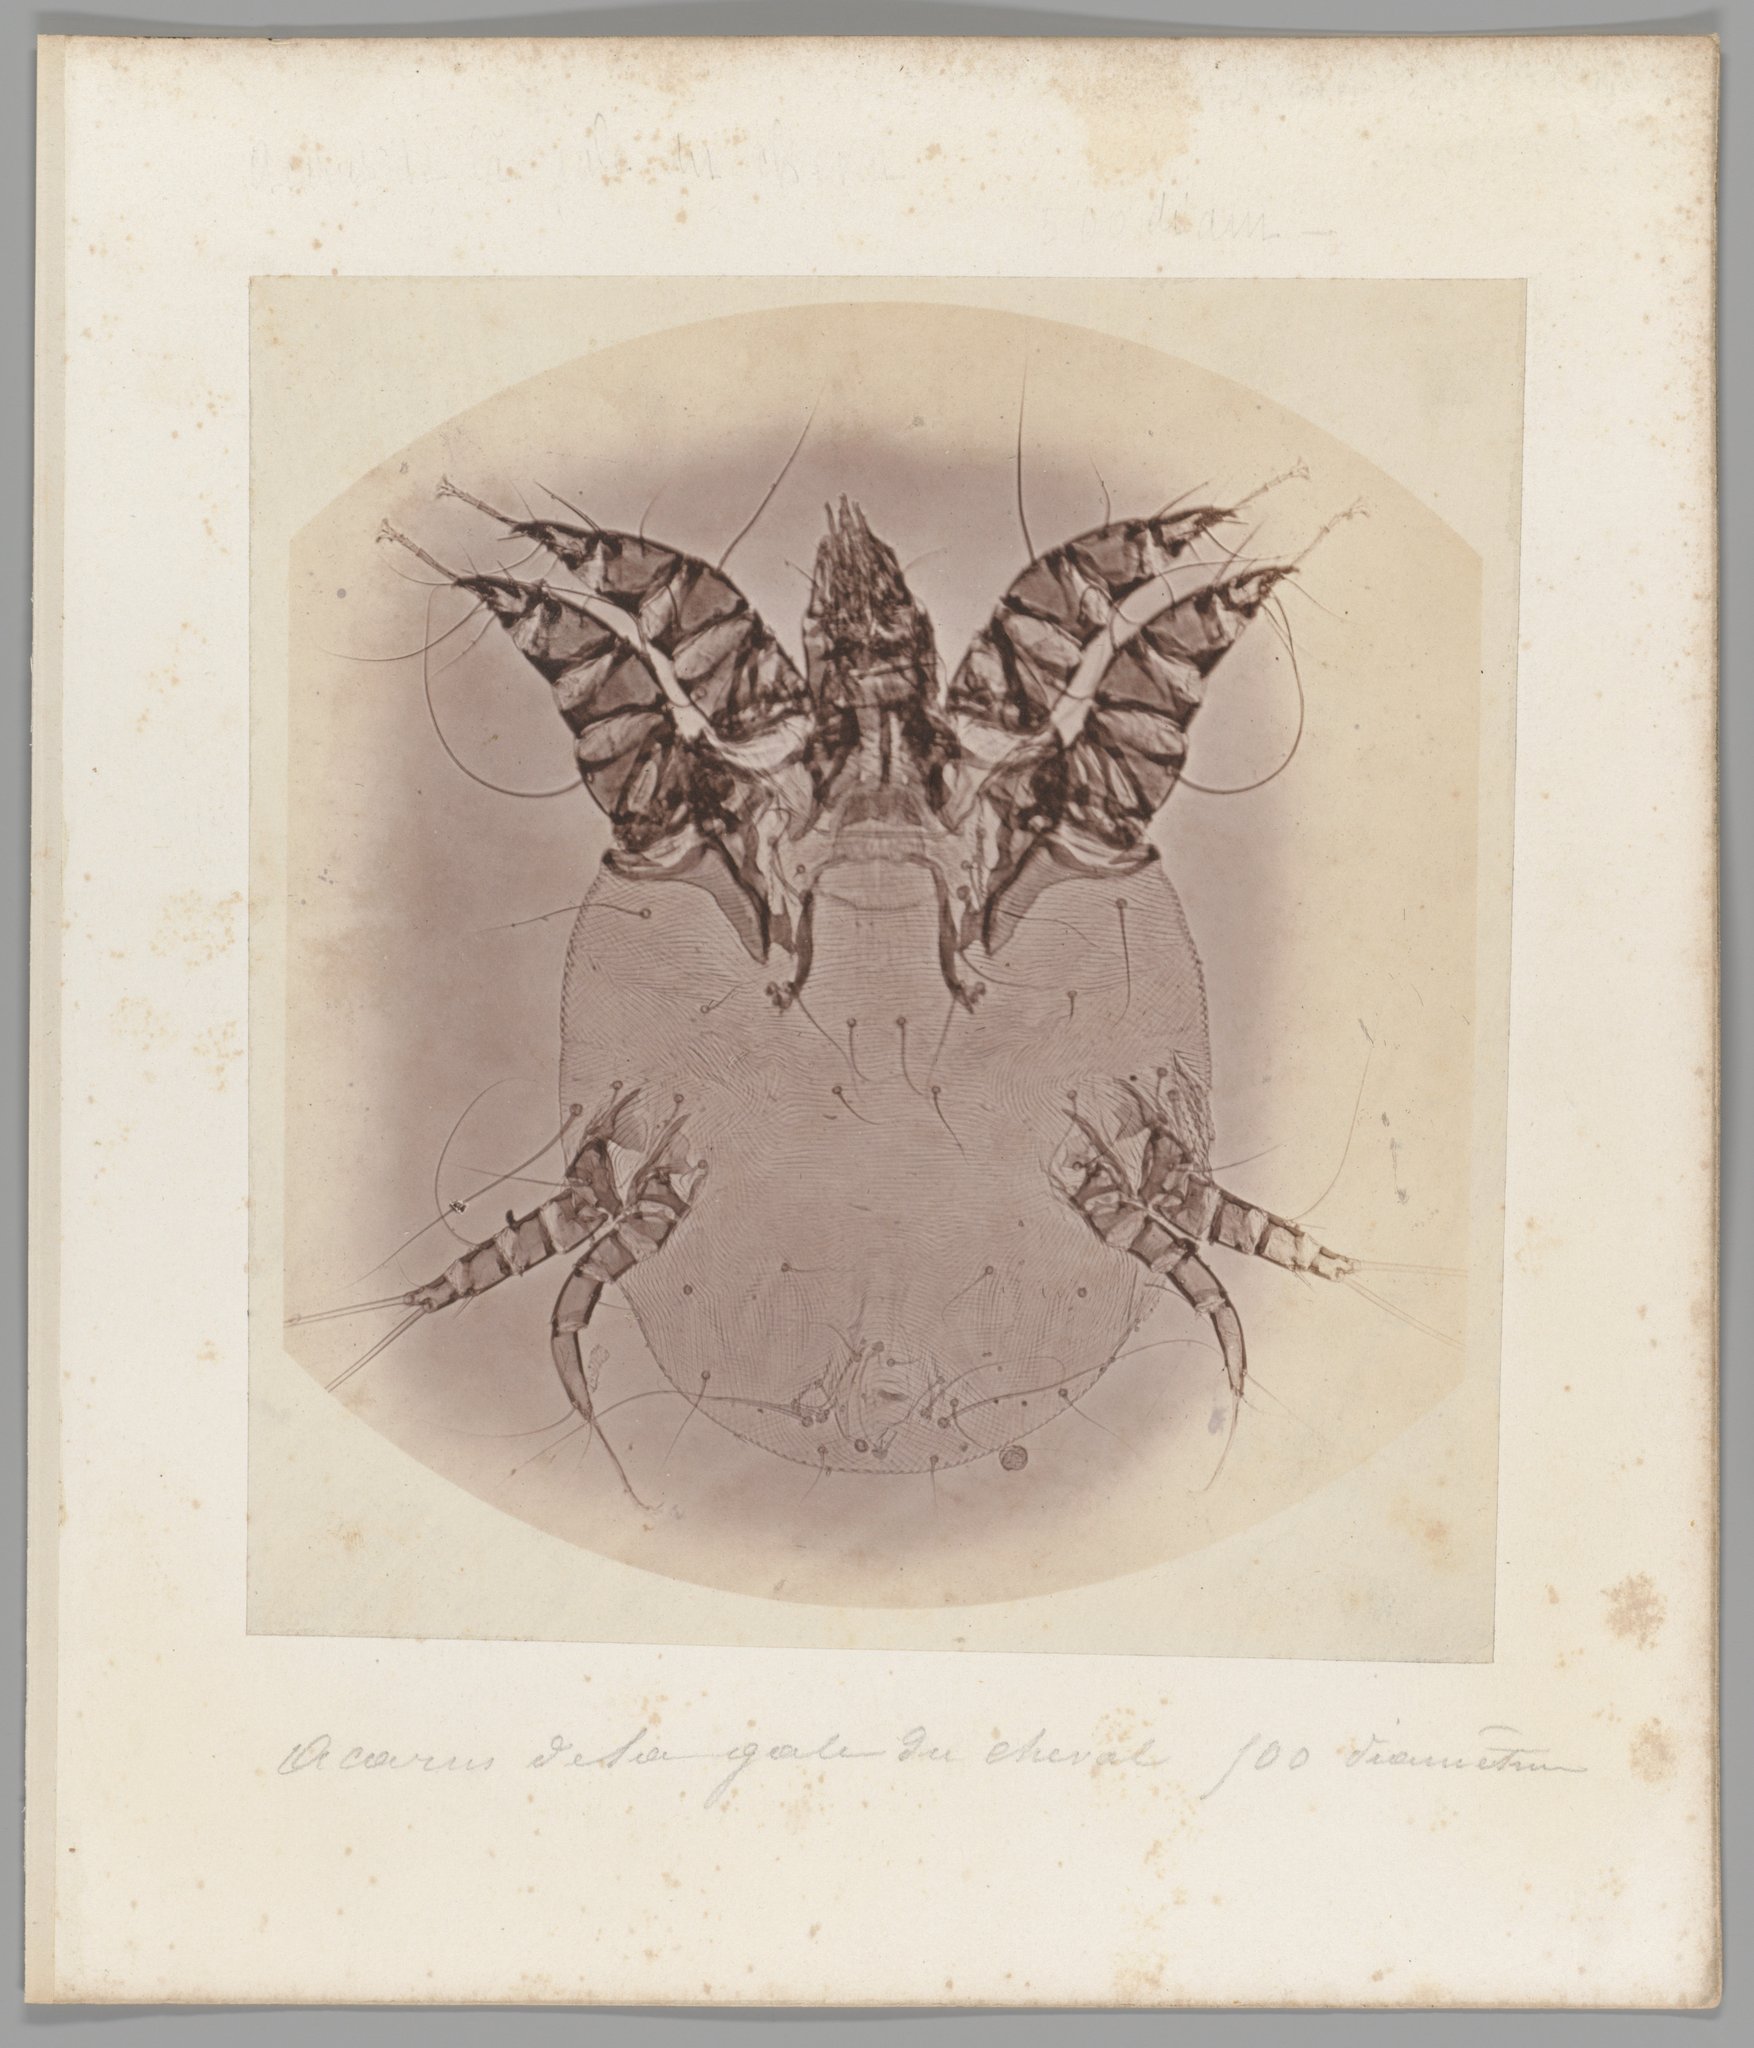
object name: photograph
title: [Untitled]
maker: auguste-adolphe bertsch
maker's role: artist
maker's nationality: french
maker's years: 1813-1871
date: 1853-1857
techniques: salted paper print